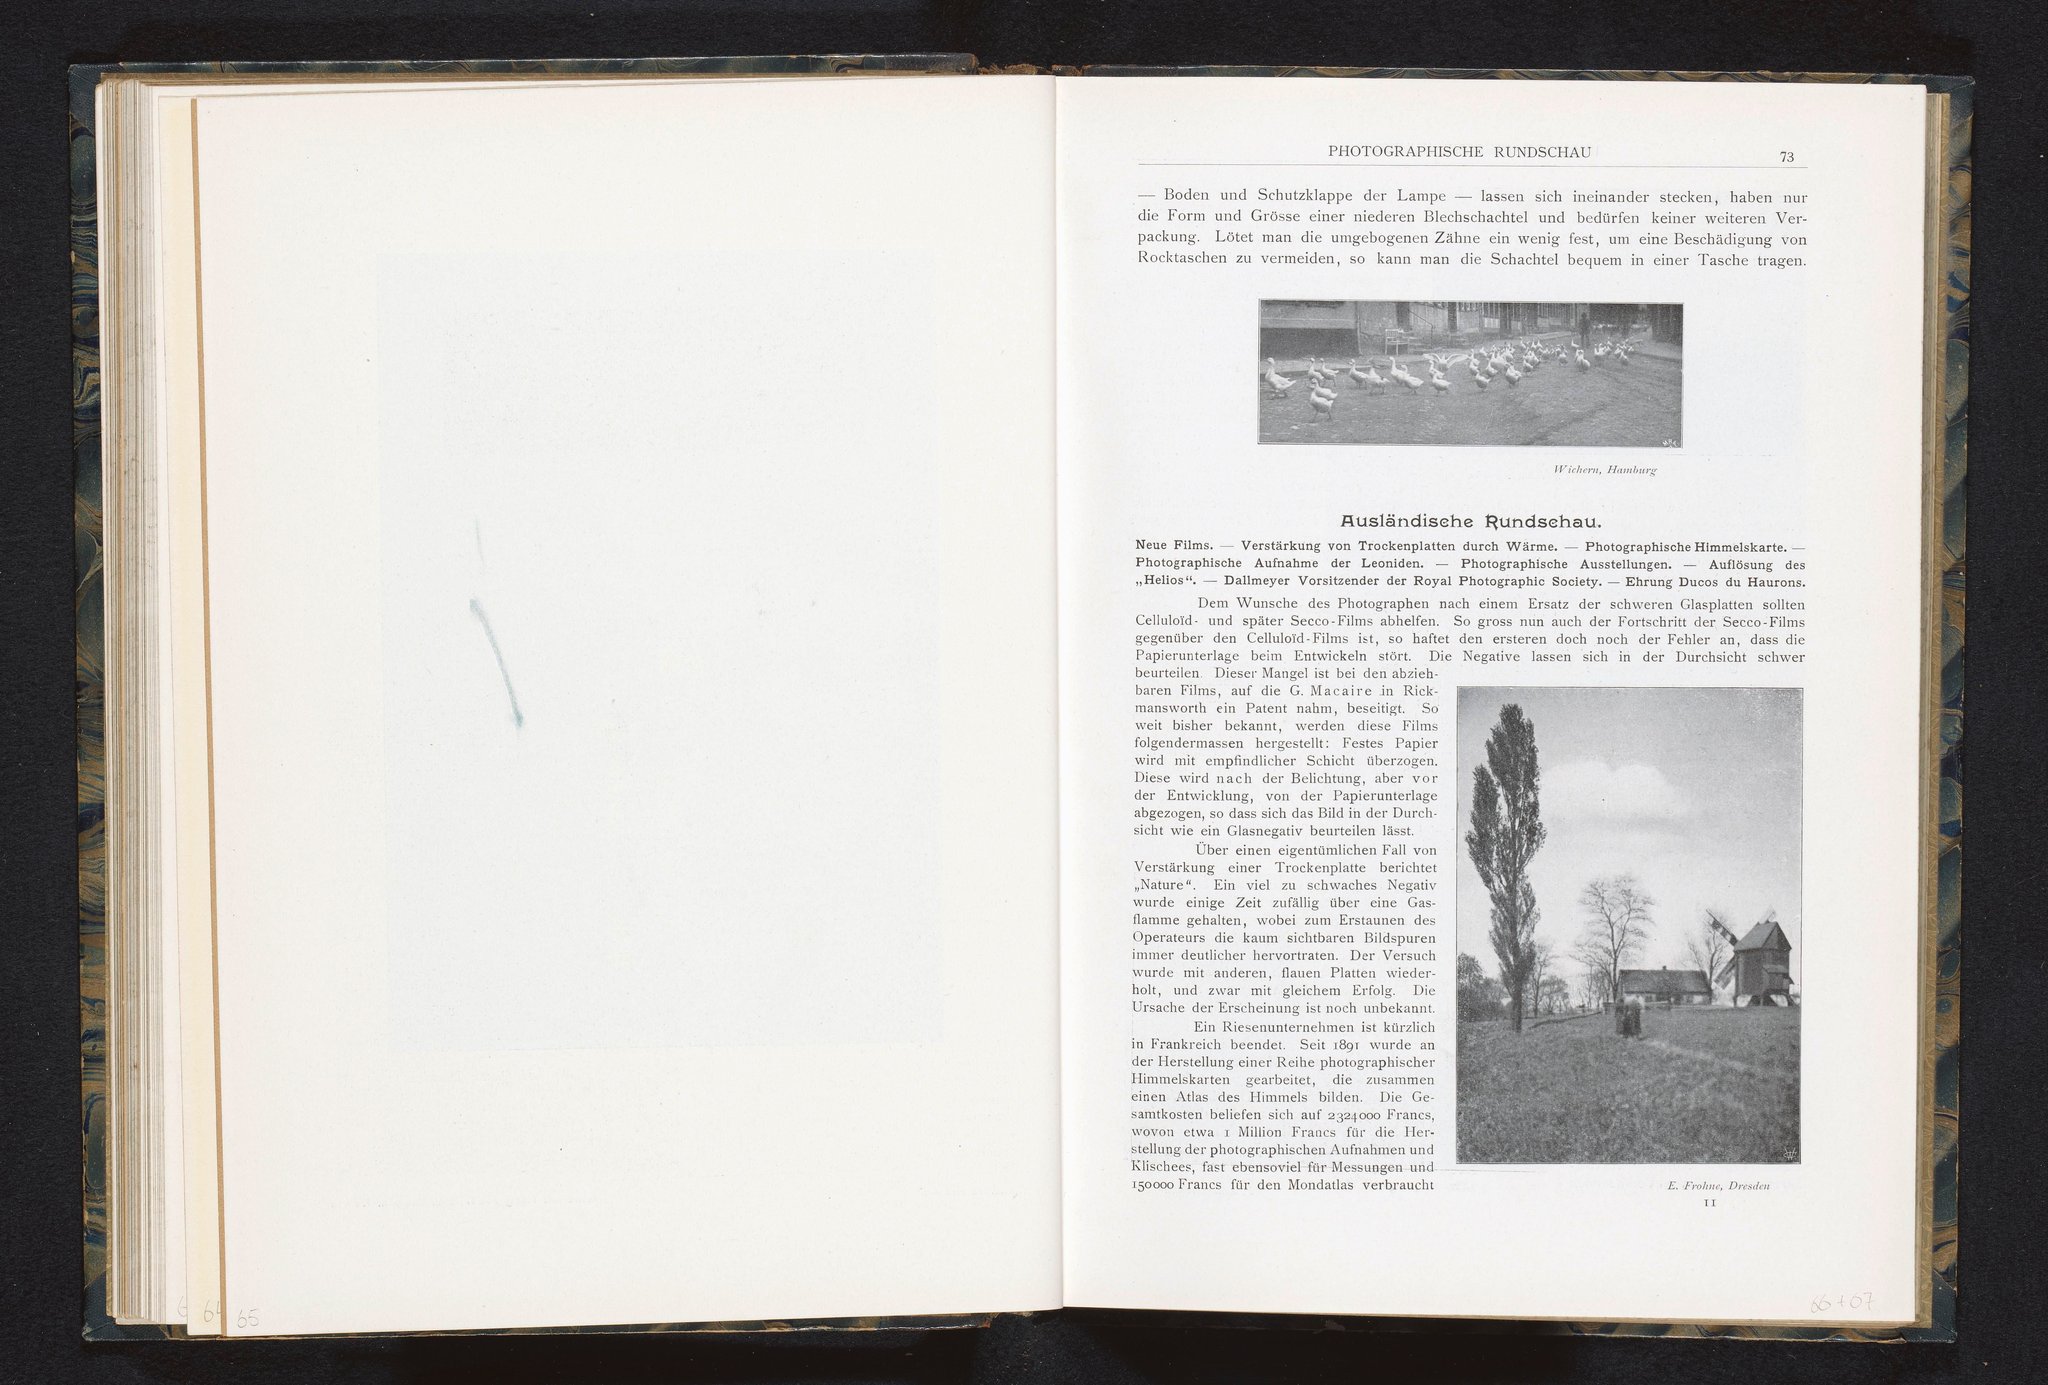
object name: photomechanical print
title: Gezicht op een troep ganzen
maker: wichern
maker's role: fotograaf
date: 1895-1900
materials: paper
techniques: autotype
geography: berlin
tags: groups of birds, geese (domestic waterbirds)